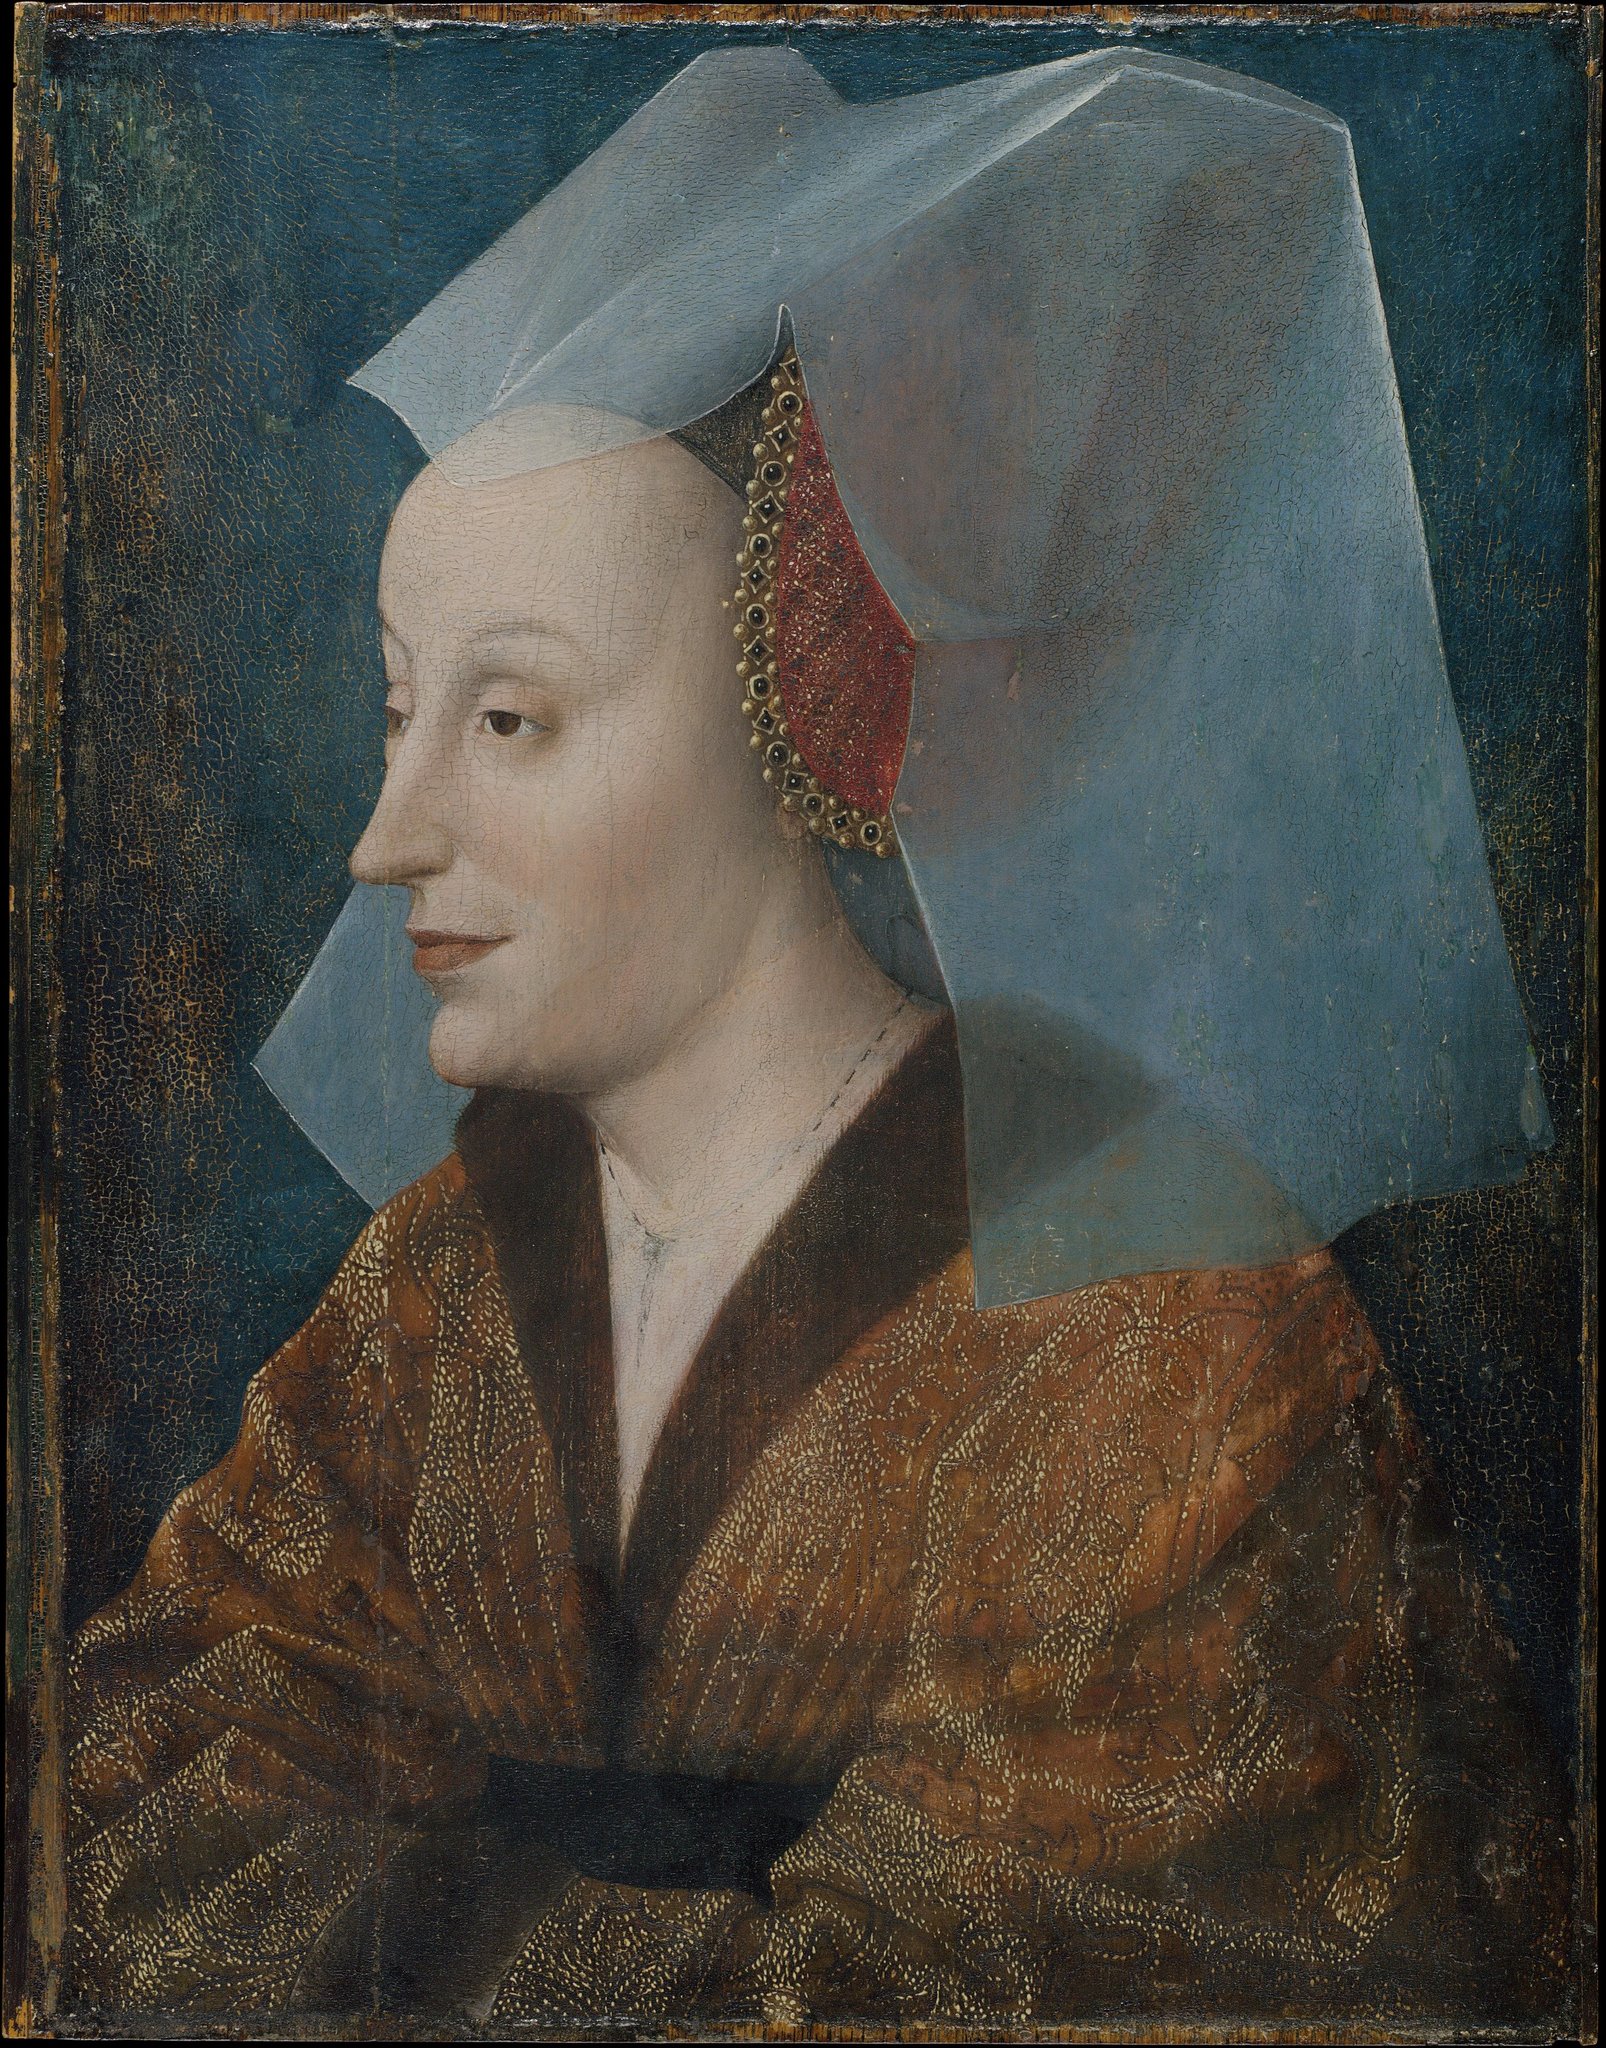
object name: painting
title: Portrait of a Noblewoman, Probably Isabella of Portugal (1397–1472)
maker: netherlandish painter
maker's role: artist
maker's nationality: netherlandish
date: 1430-1469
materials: oil, wood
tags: portraits,women